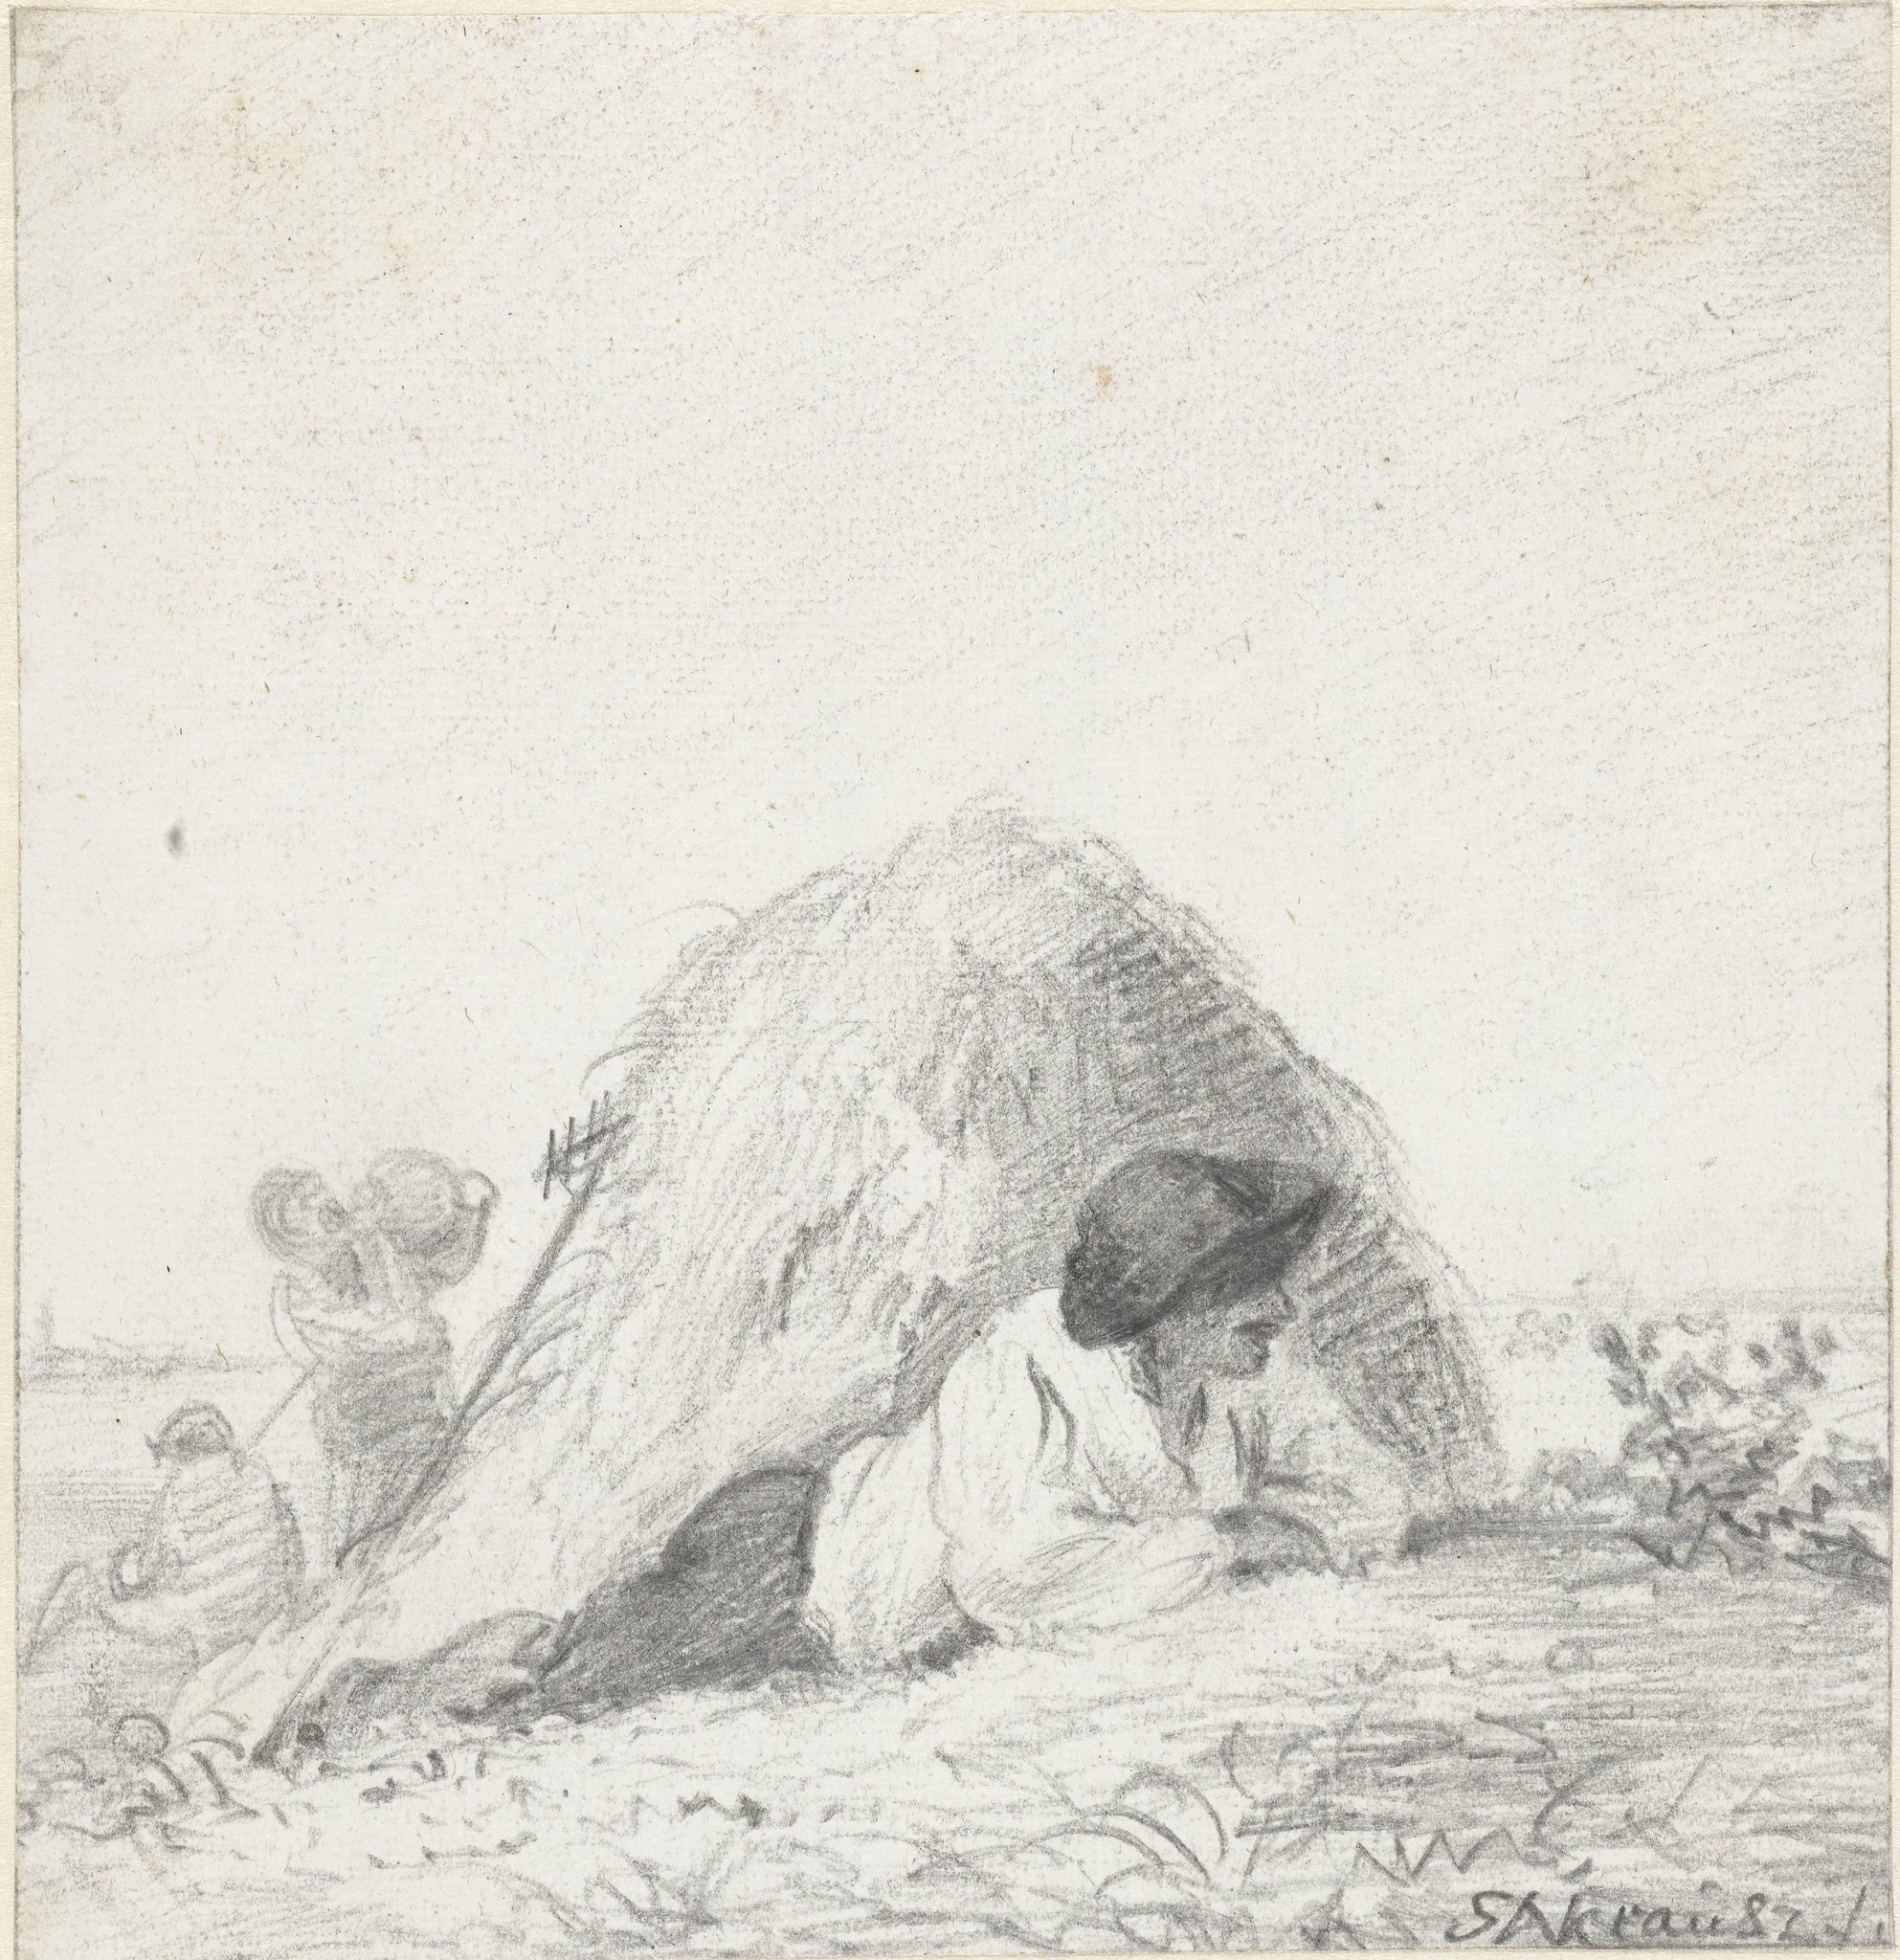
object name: drawing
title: Rustende hooier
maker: simon andreas krausz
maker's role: draughtsman, print maker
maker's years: 1760-1825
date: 1770-1825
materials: paper, pencil